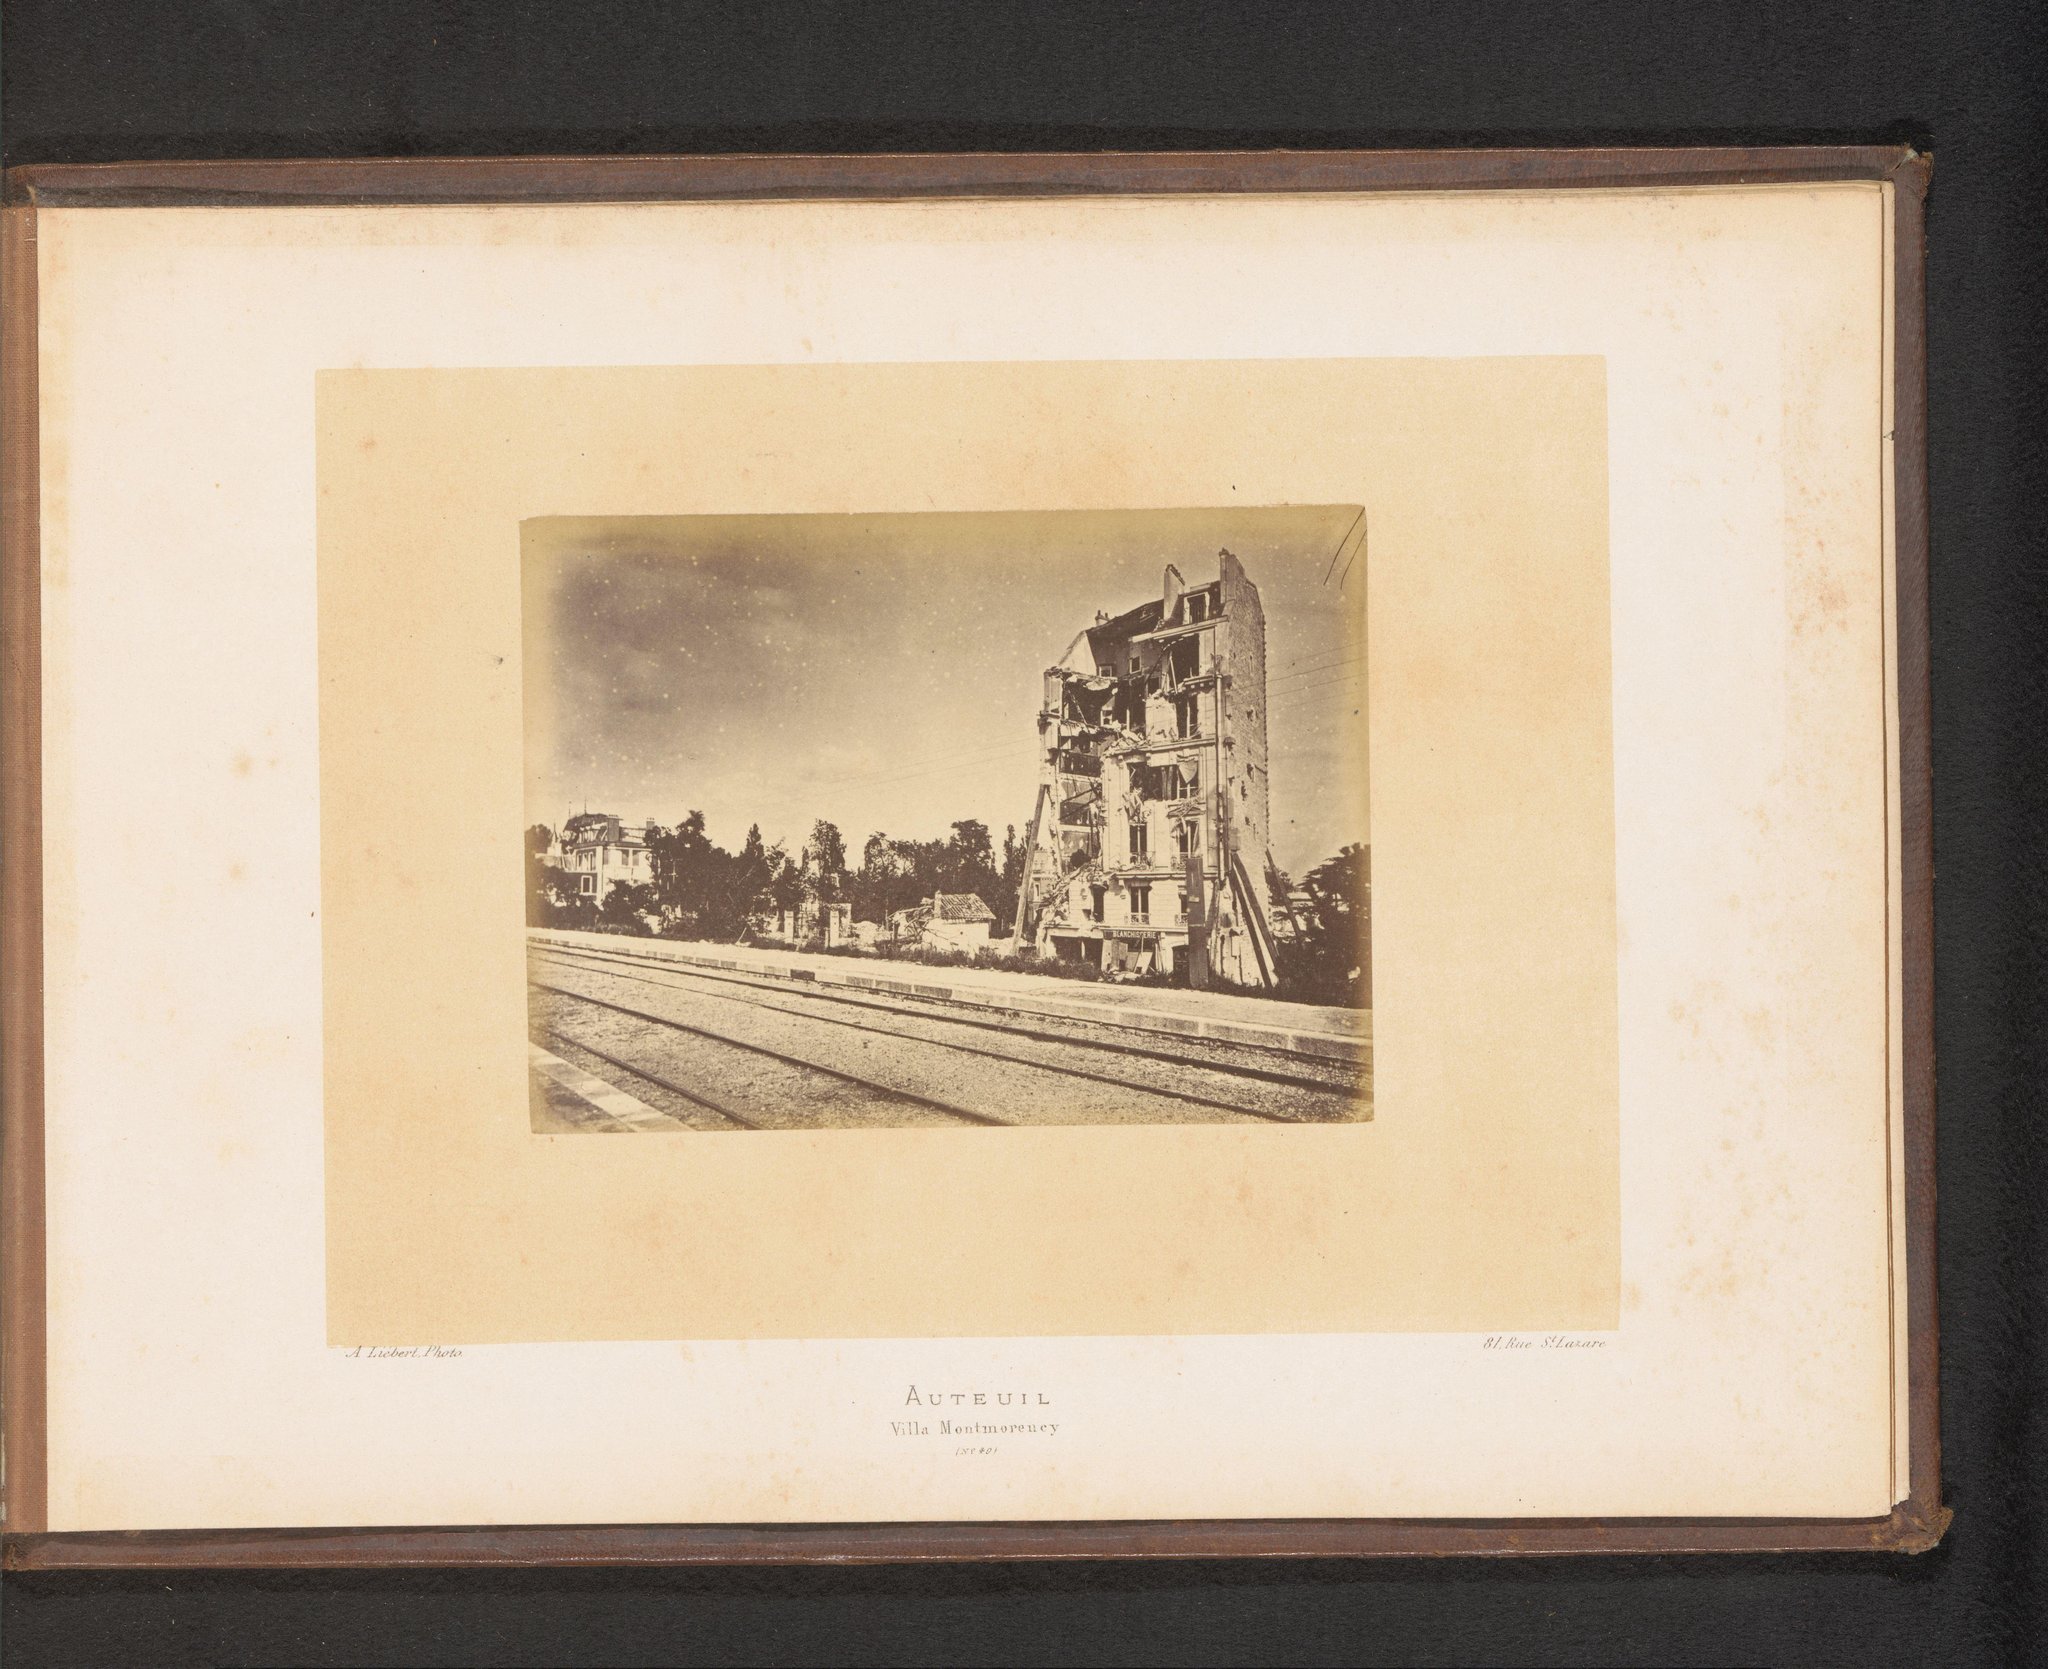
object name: page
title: Gezicht op Villa Montmorency bij Gare d'Auteuil in Parijs na de brand door de Commune van Parijs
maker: alphonse-justin liébert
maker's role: fotograaf, marinier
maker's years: 1827-1914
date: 1871-1872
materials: photographic support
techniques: albumen print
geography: paris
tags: ruin of a building ~ architecture, villa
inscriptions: address: ‘31, Rue St. Lazare’, number: ‘(No. 49)’